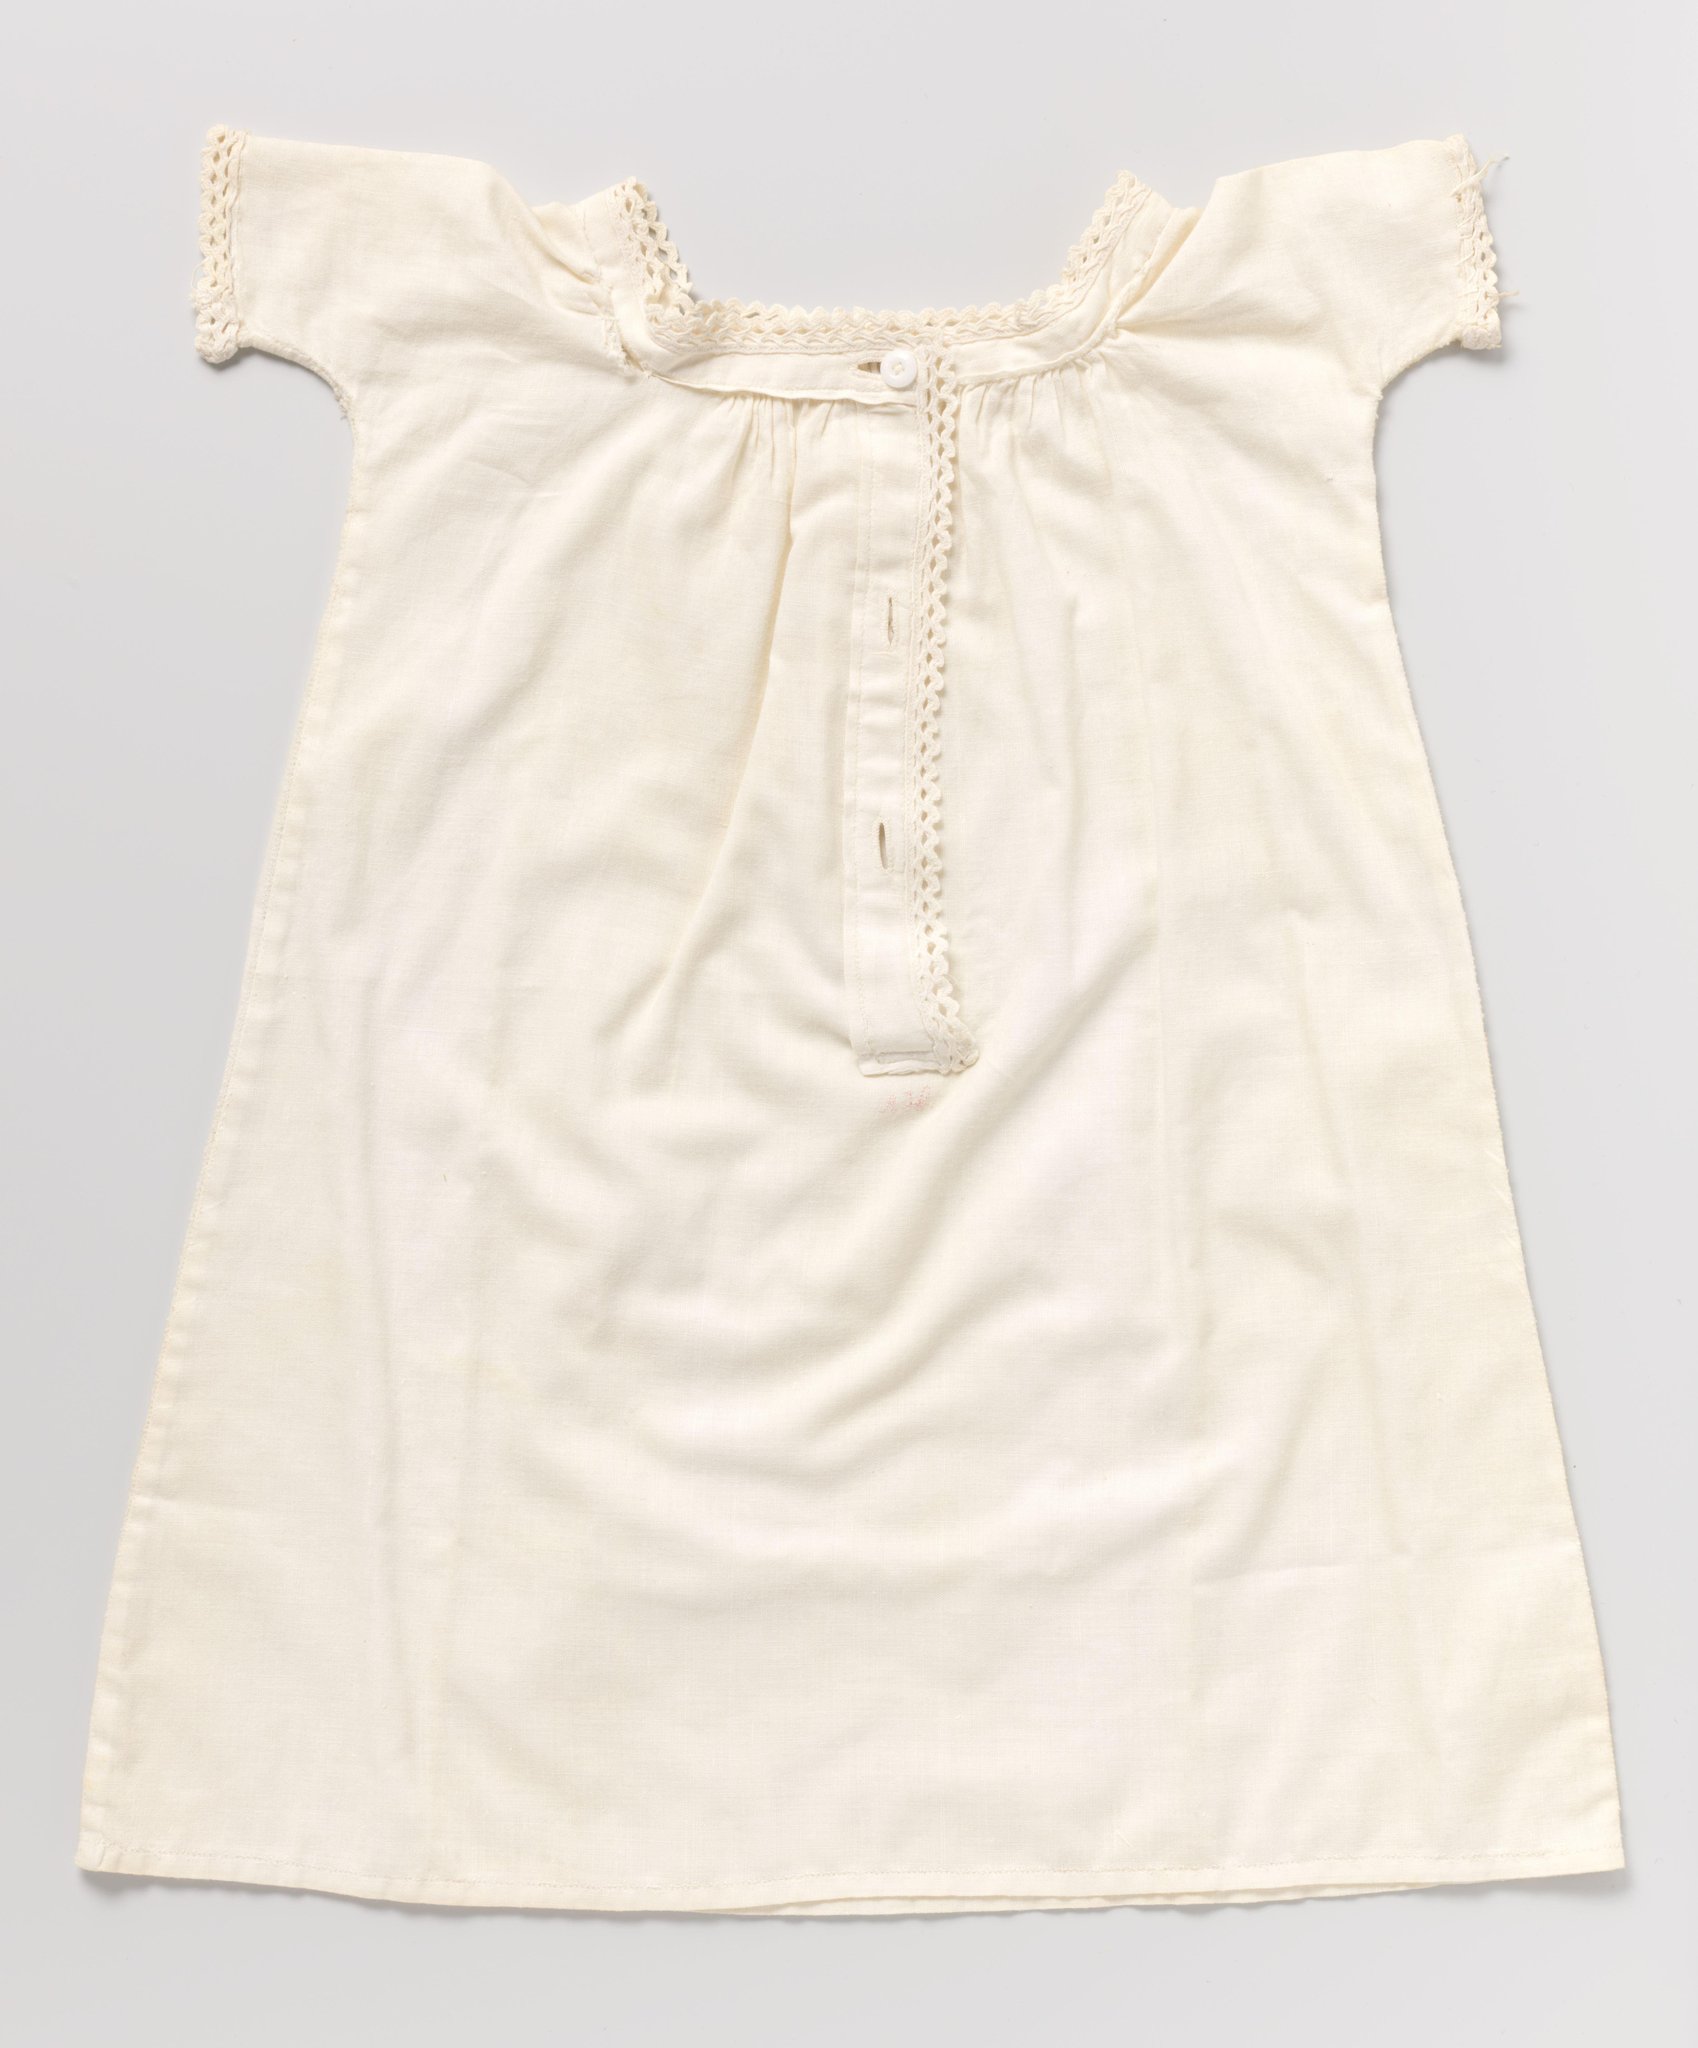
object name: underwear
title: Nachtjapon van katoen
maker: Anonymous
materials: cotton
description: Nachtjapon van katoen. Deel van een stel ondergoed.